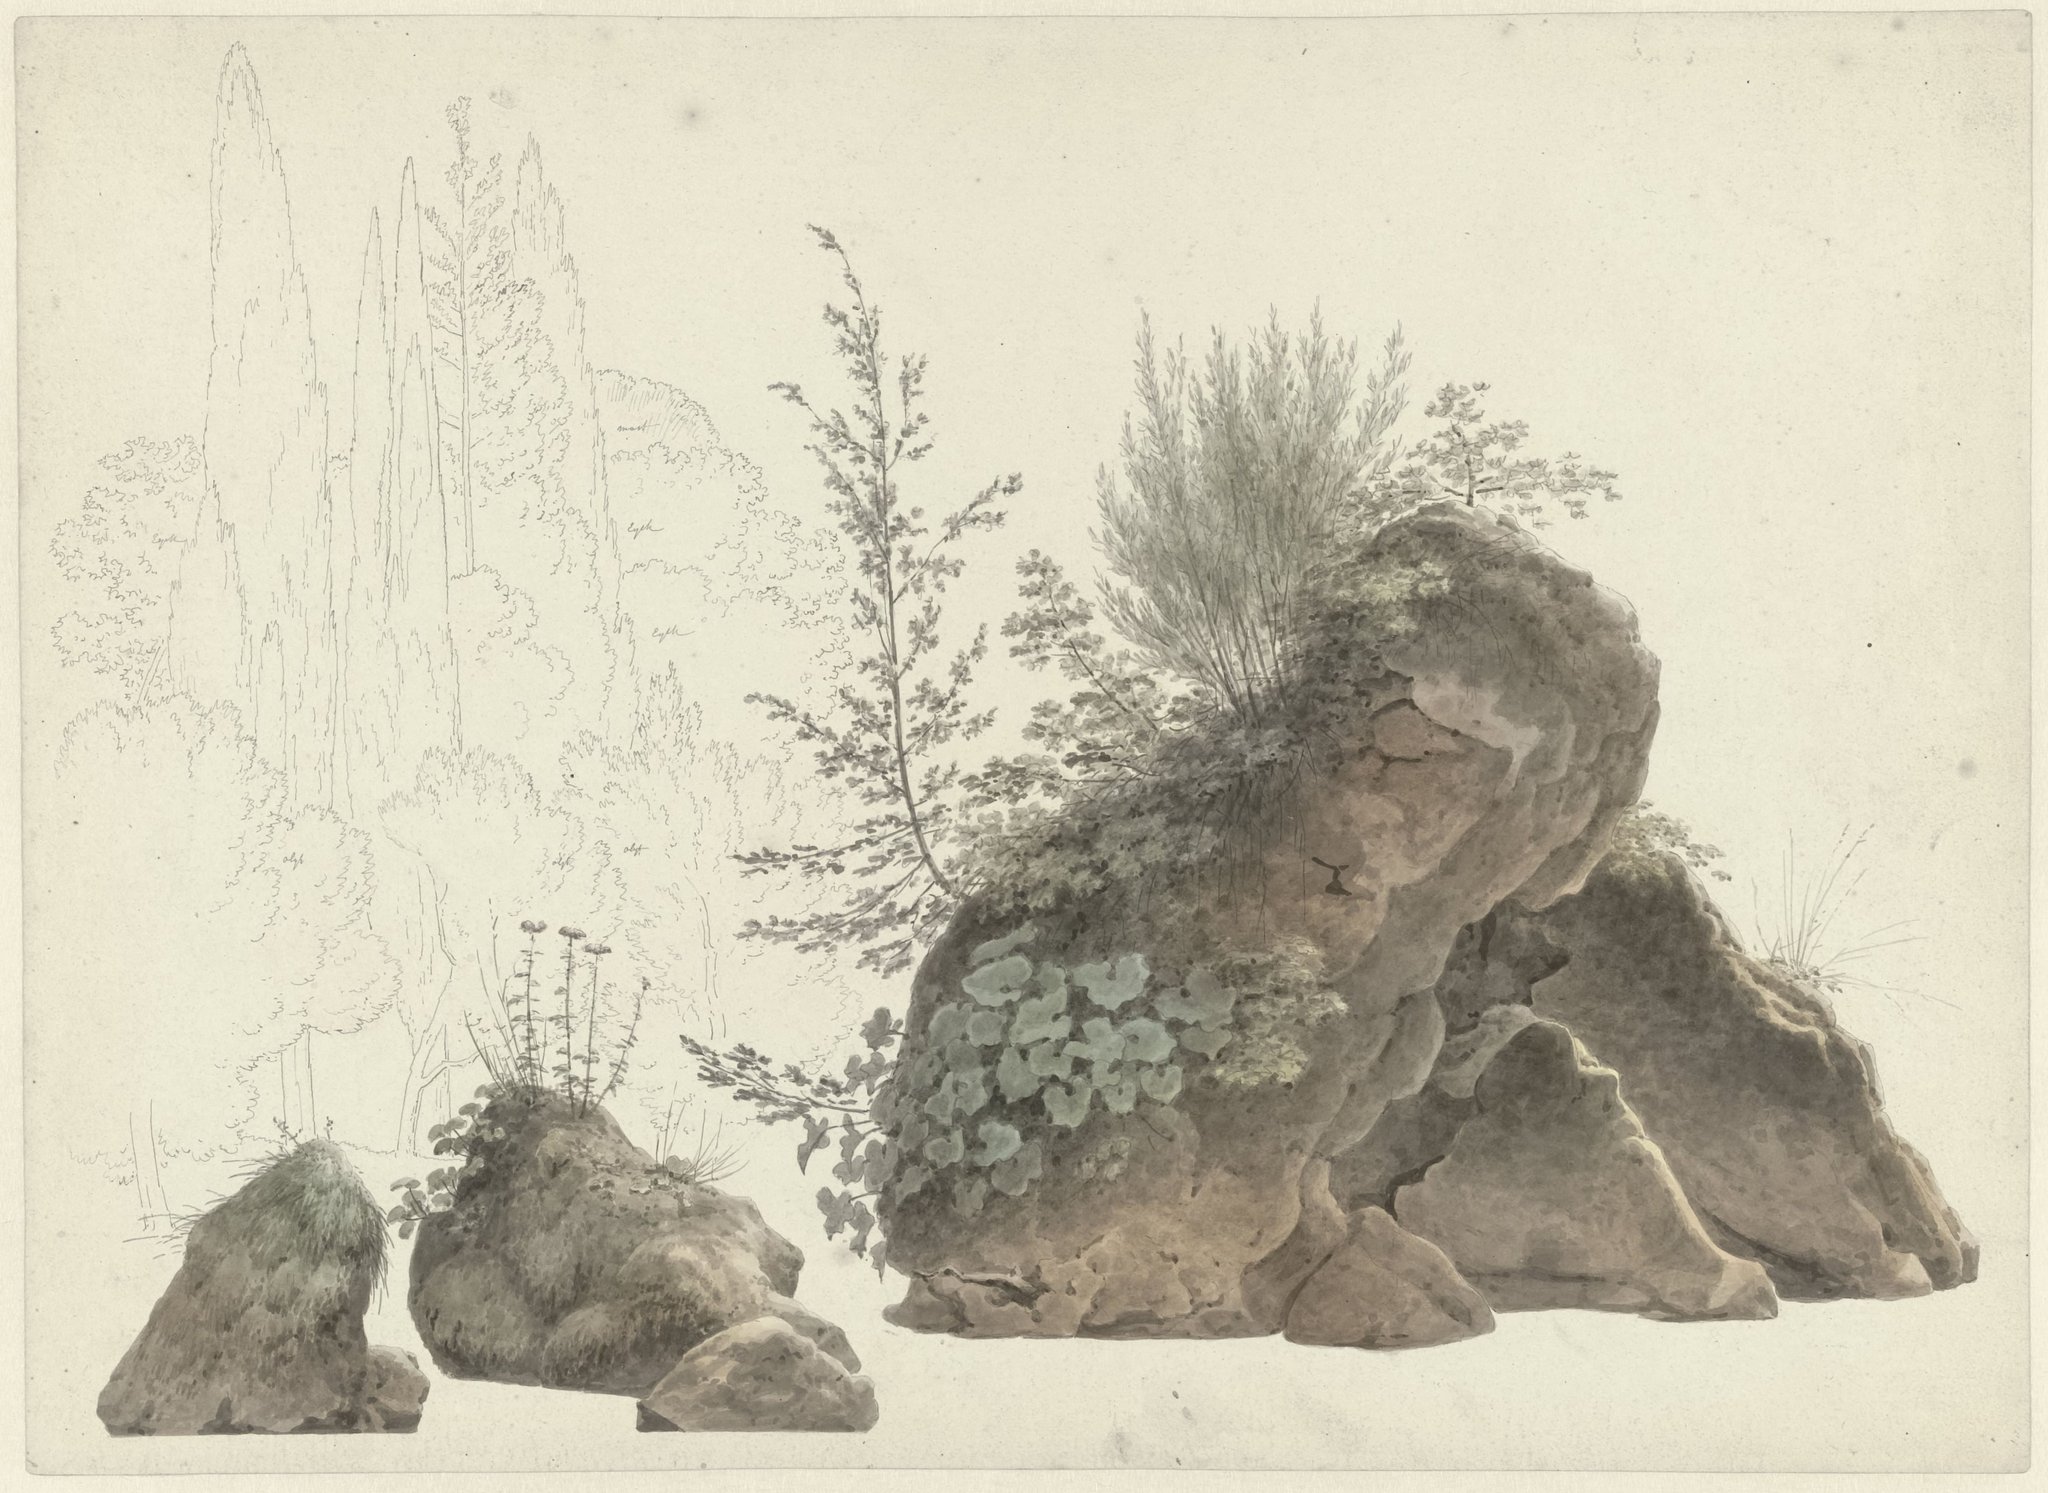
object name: drawing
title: Overgrown Rocks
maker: josephus augustus knip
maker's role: draughtsman, painter, print maker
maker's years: 1777-1847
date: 1809-1812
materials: graphite, paper, watercolor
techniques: brush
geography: italy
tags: boulder, stone, italy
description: Some worked-up, overgrown rocks, and a pair of cypresses and other trees drawn in outline, and nothing else. With Knip, less is often more: the simpler the motif, the more impressive the drawing. Unfortunately, the draughtsman neglected to note where he recorded this little patch of nature, but judging from the cypresses at the left, it must have been in Italy.